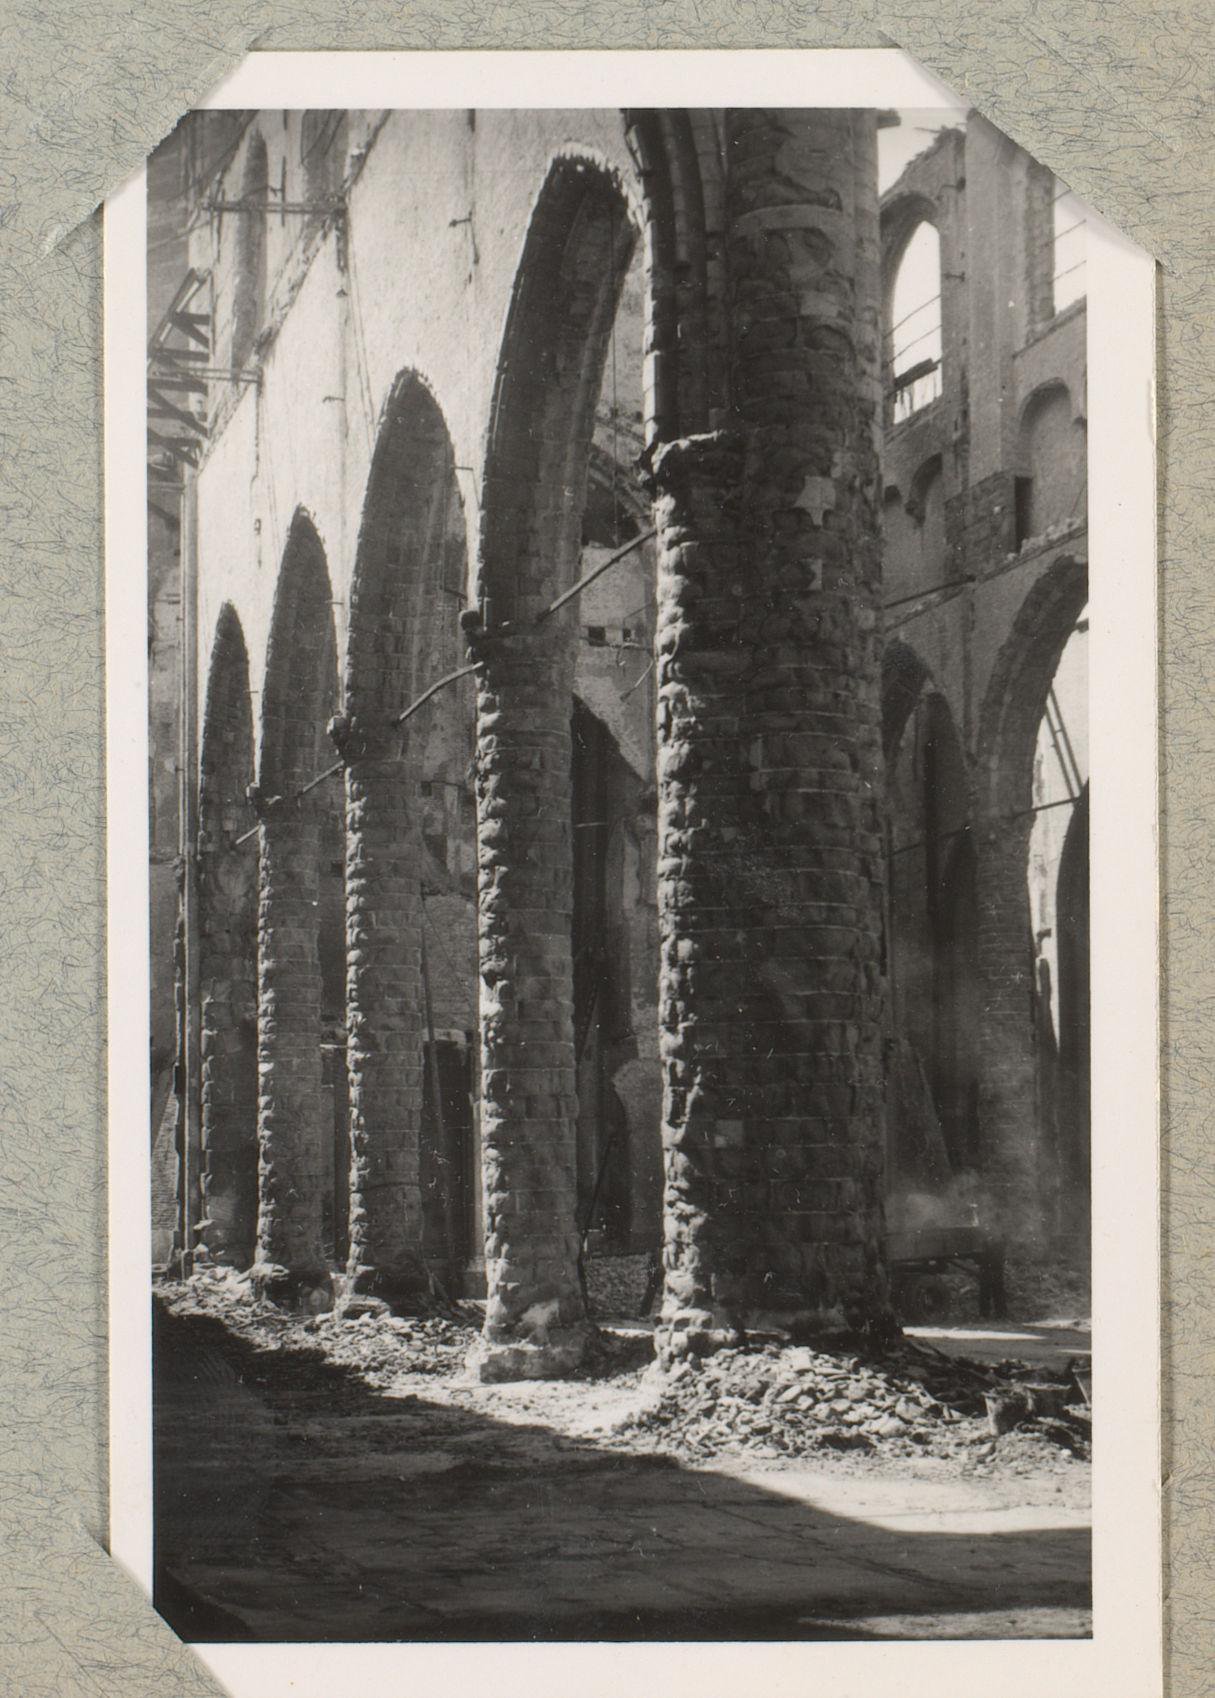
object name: ansichtkaart, prentbriefkaart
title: Ruïne van de Laurenskerk te Rotterdam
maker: j. nolte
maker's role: fotograaf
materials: photographic support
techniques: gelatin silver print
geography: rotterdam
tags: ruin of church, monastery, etc. - qq - small church, chapel, devastated, ruined place or city (~ warfare), rotterdam blitz